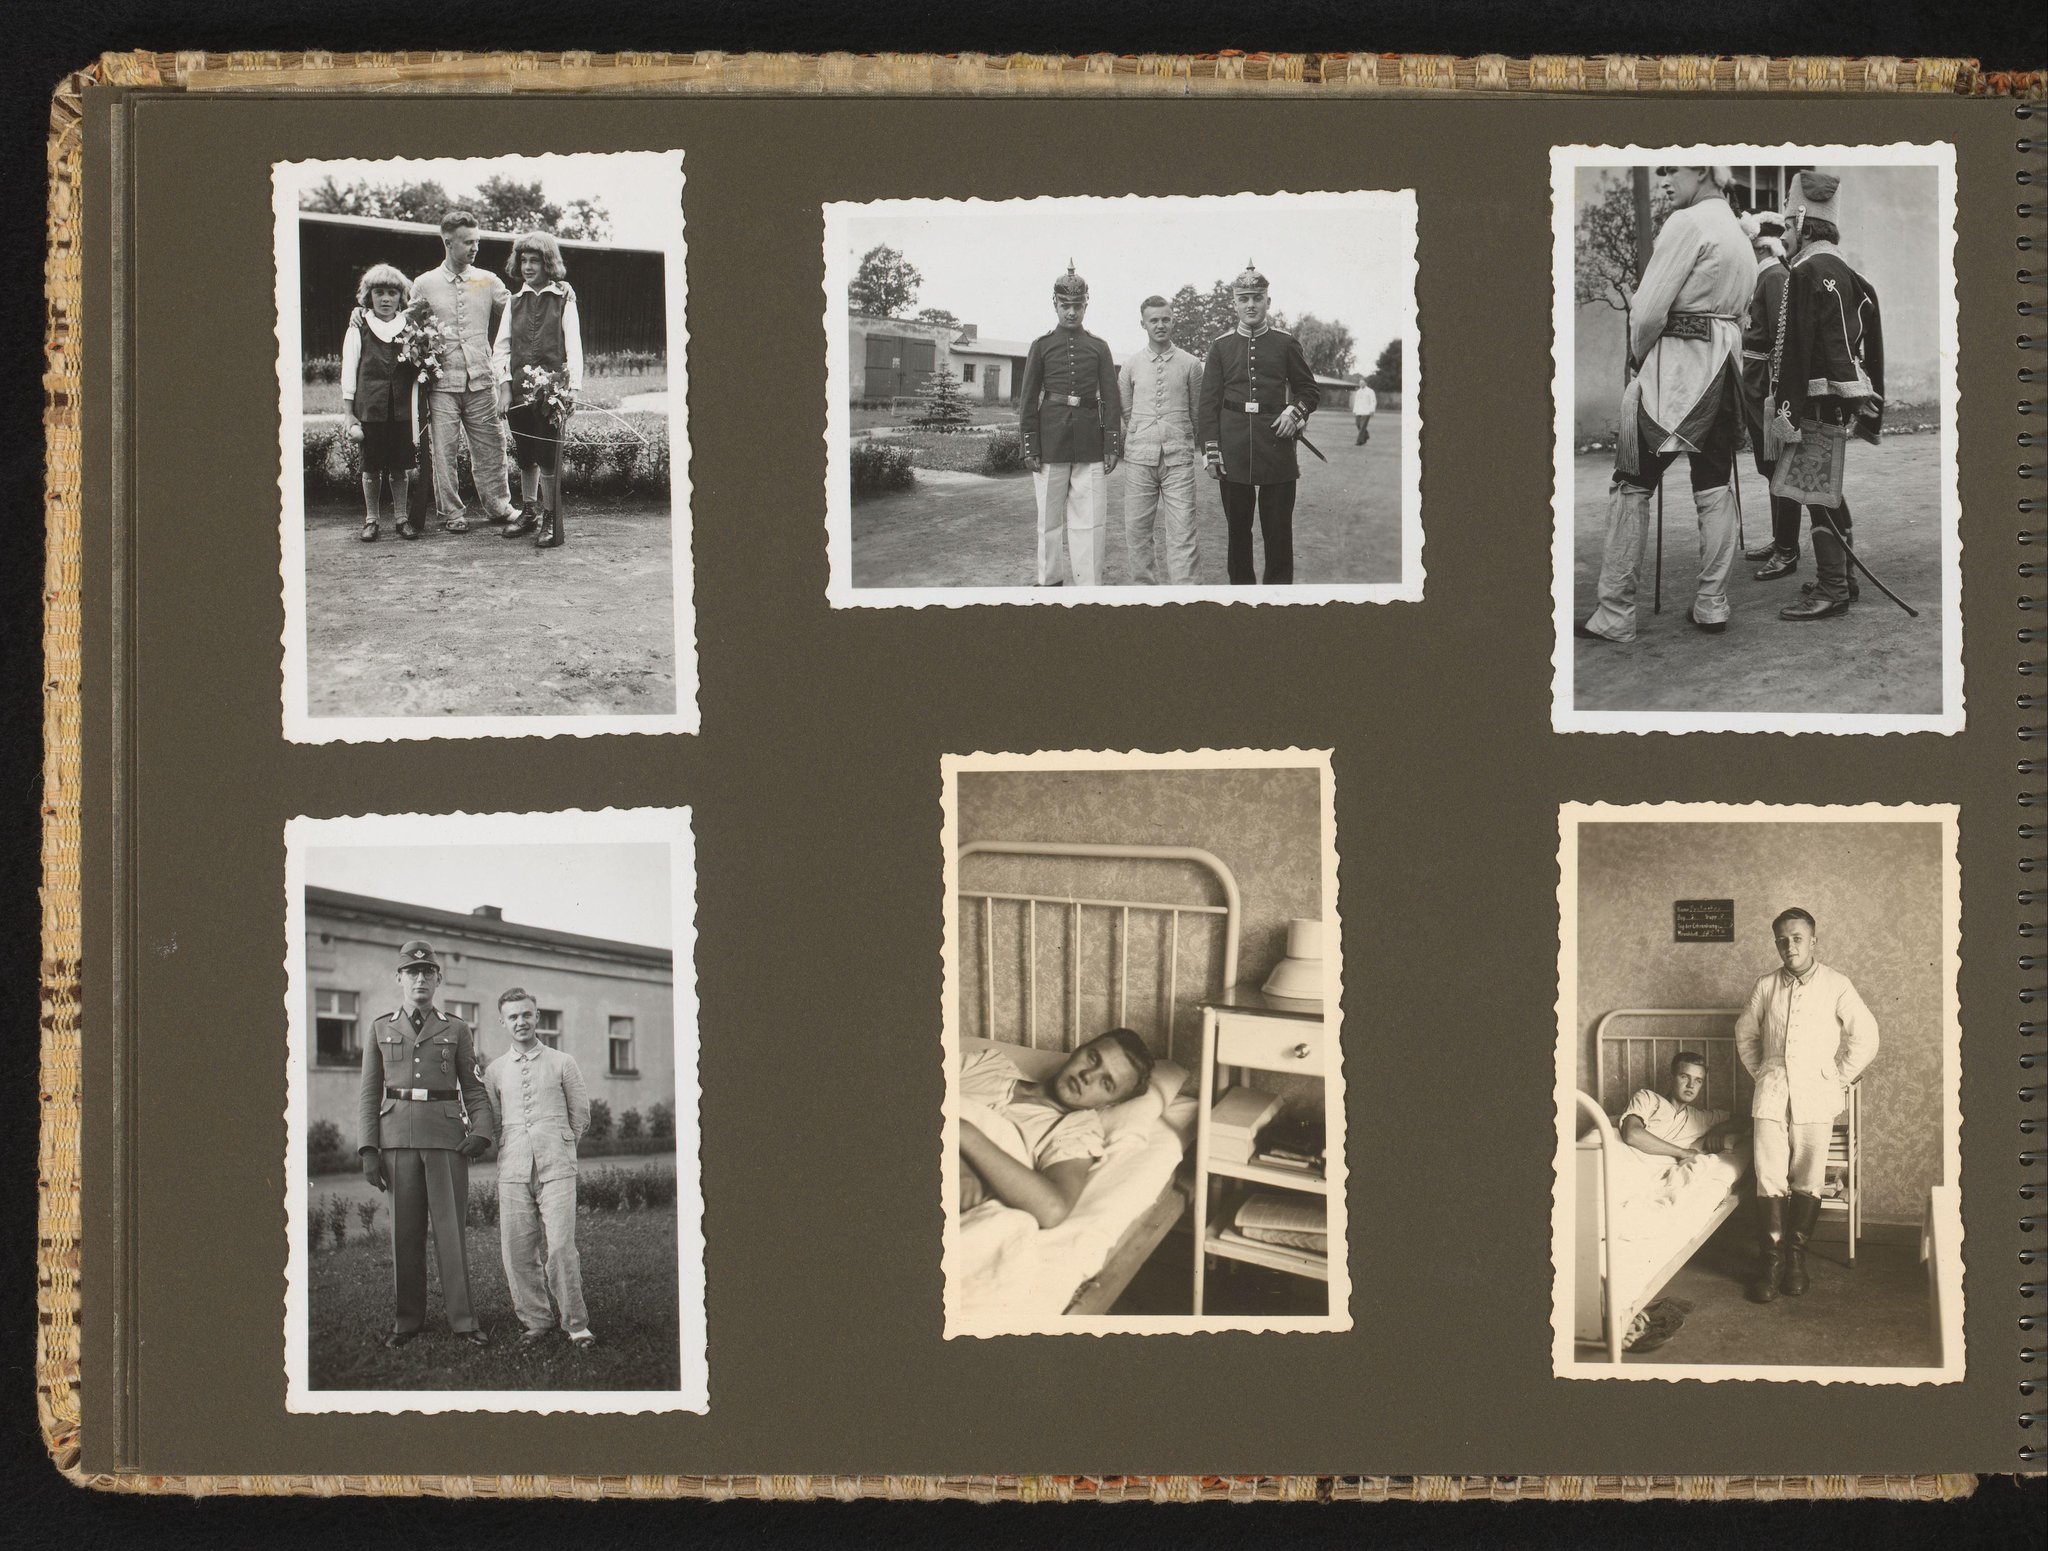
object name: album leaf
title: Opleiding in de Reichsarbeitsdienst en militaire dienst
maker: Anonymous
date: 1935-1940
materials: cardboard, photographic support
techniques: gelatin silver print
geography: germany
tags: military training, germany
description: Albumblad met zes foto's. Drie van een verkleedpartij in historische militaire uniformen in de Reichsarbeitsdienst, verder nog twee foto's in een ziekenhuis. Onderdeel van het fotoalbum Duitse bezetting van Nederland.